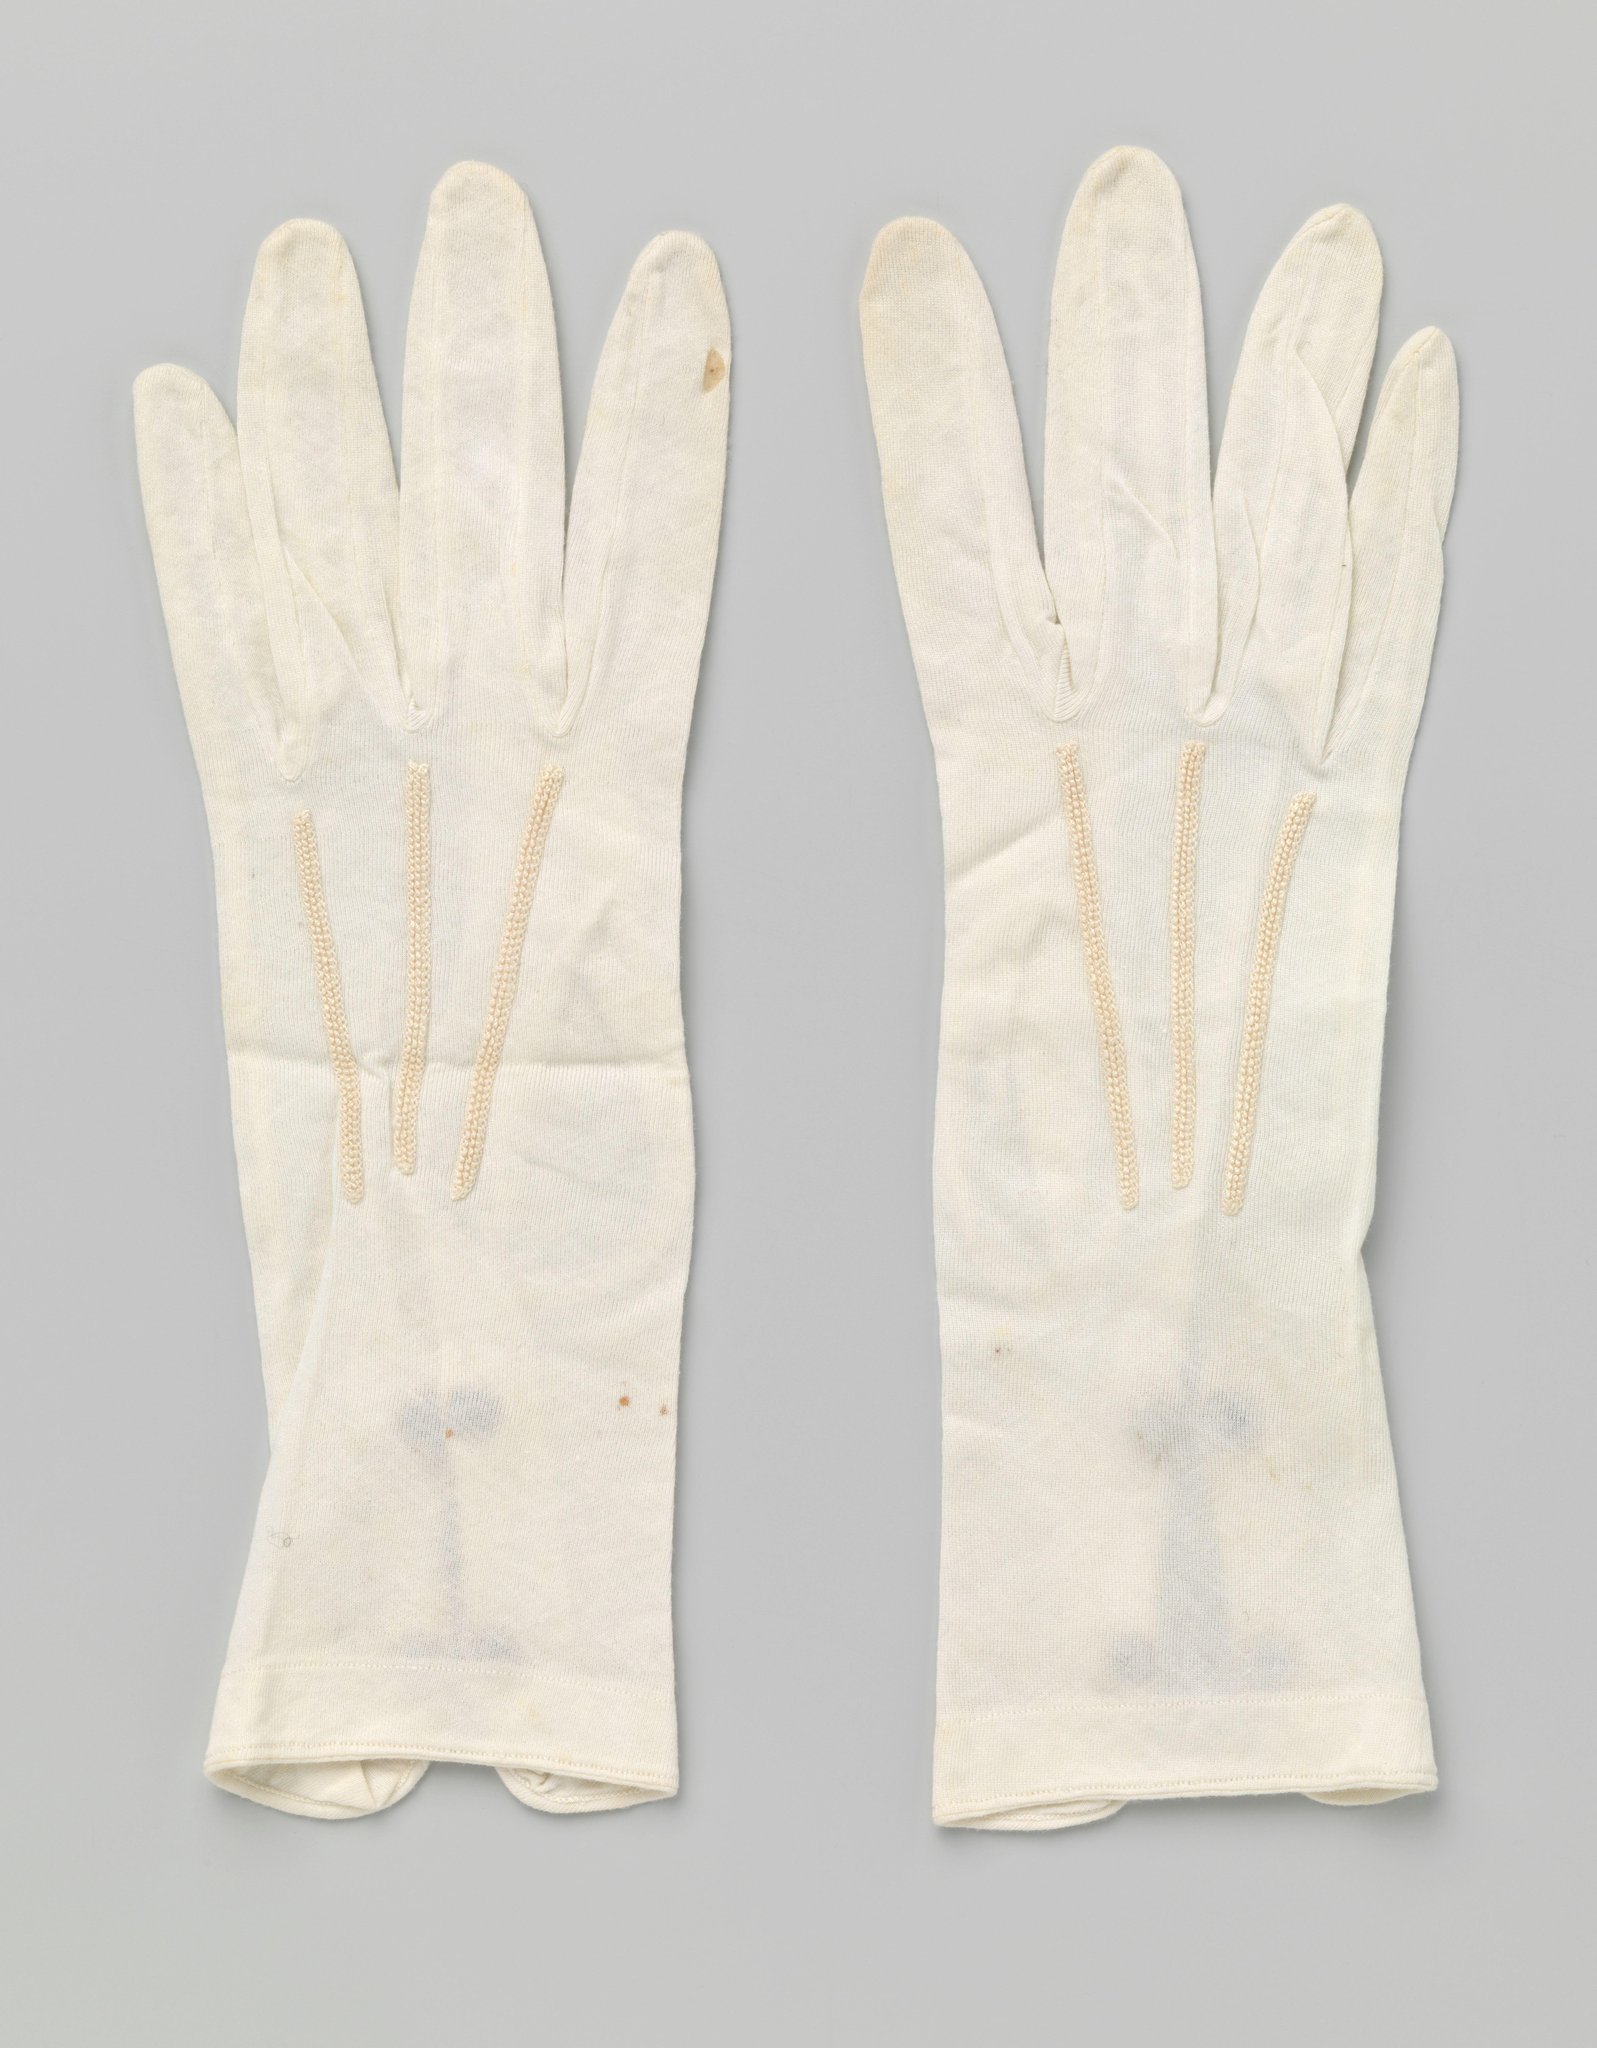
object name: glove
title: Handschoen van witte tricot met split en twee drukknopen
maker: Anonymous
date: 1900-1925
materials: cotton, plastic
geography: netherlands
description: Linker handschoen, deel van een paar, van witte katoenen tricot met split en twee drukknopen.